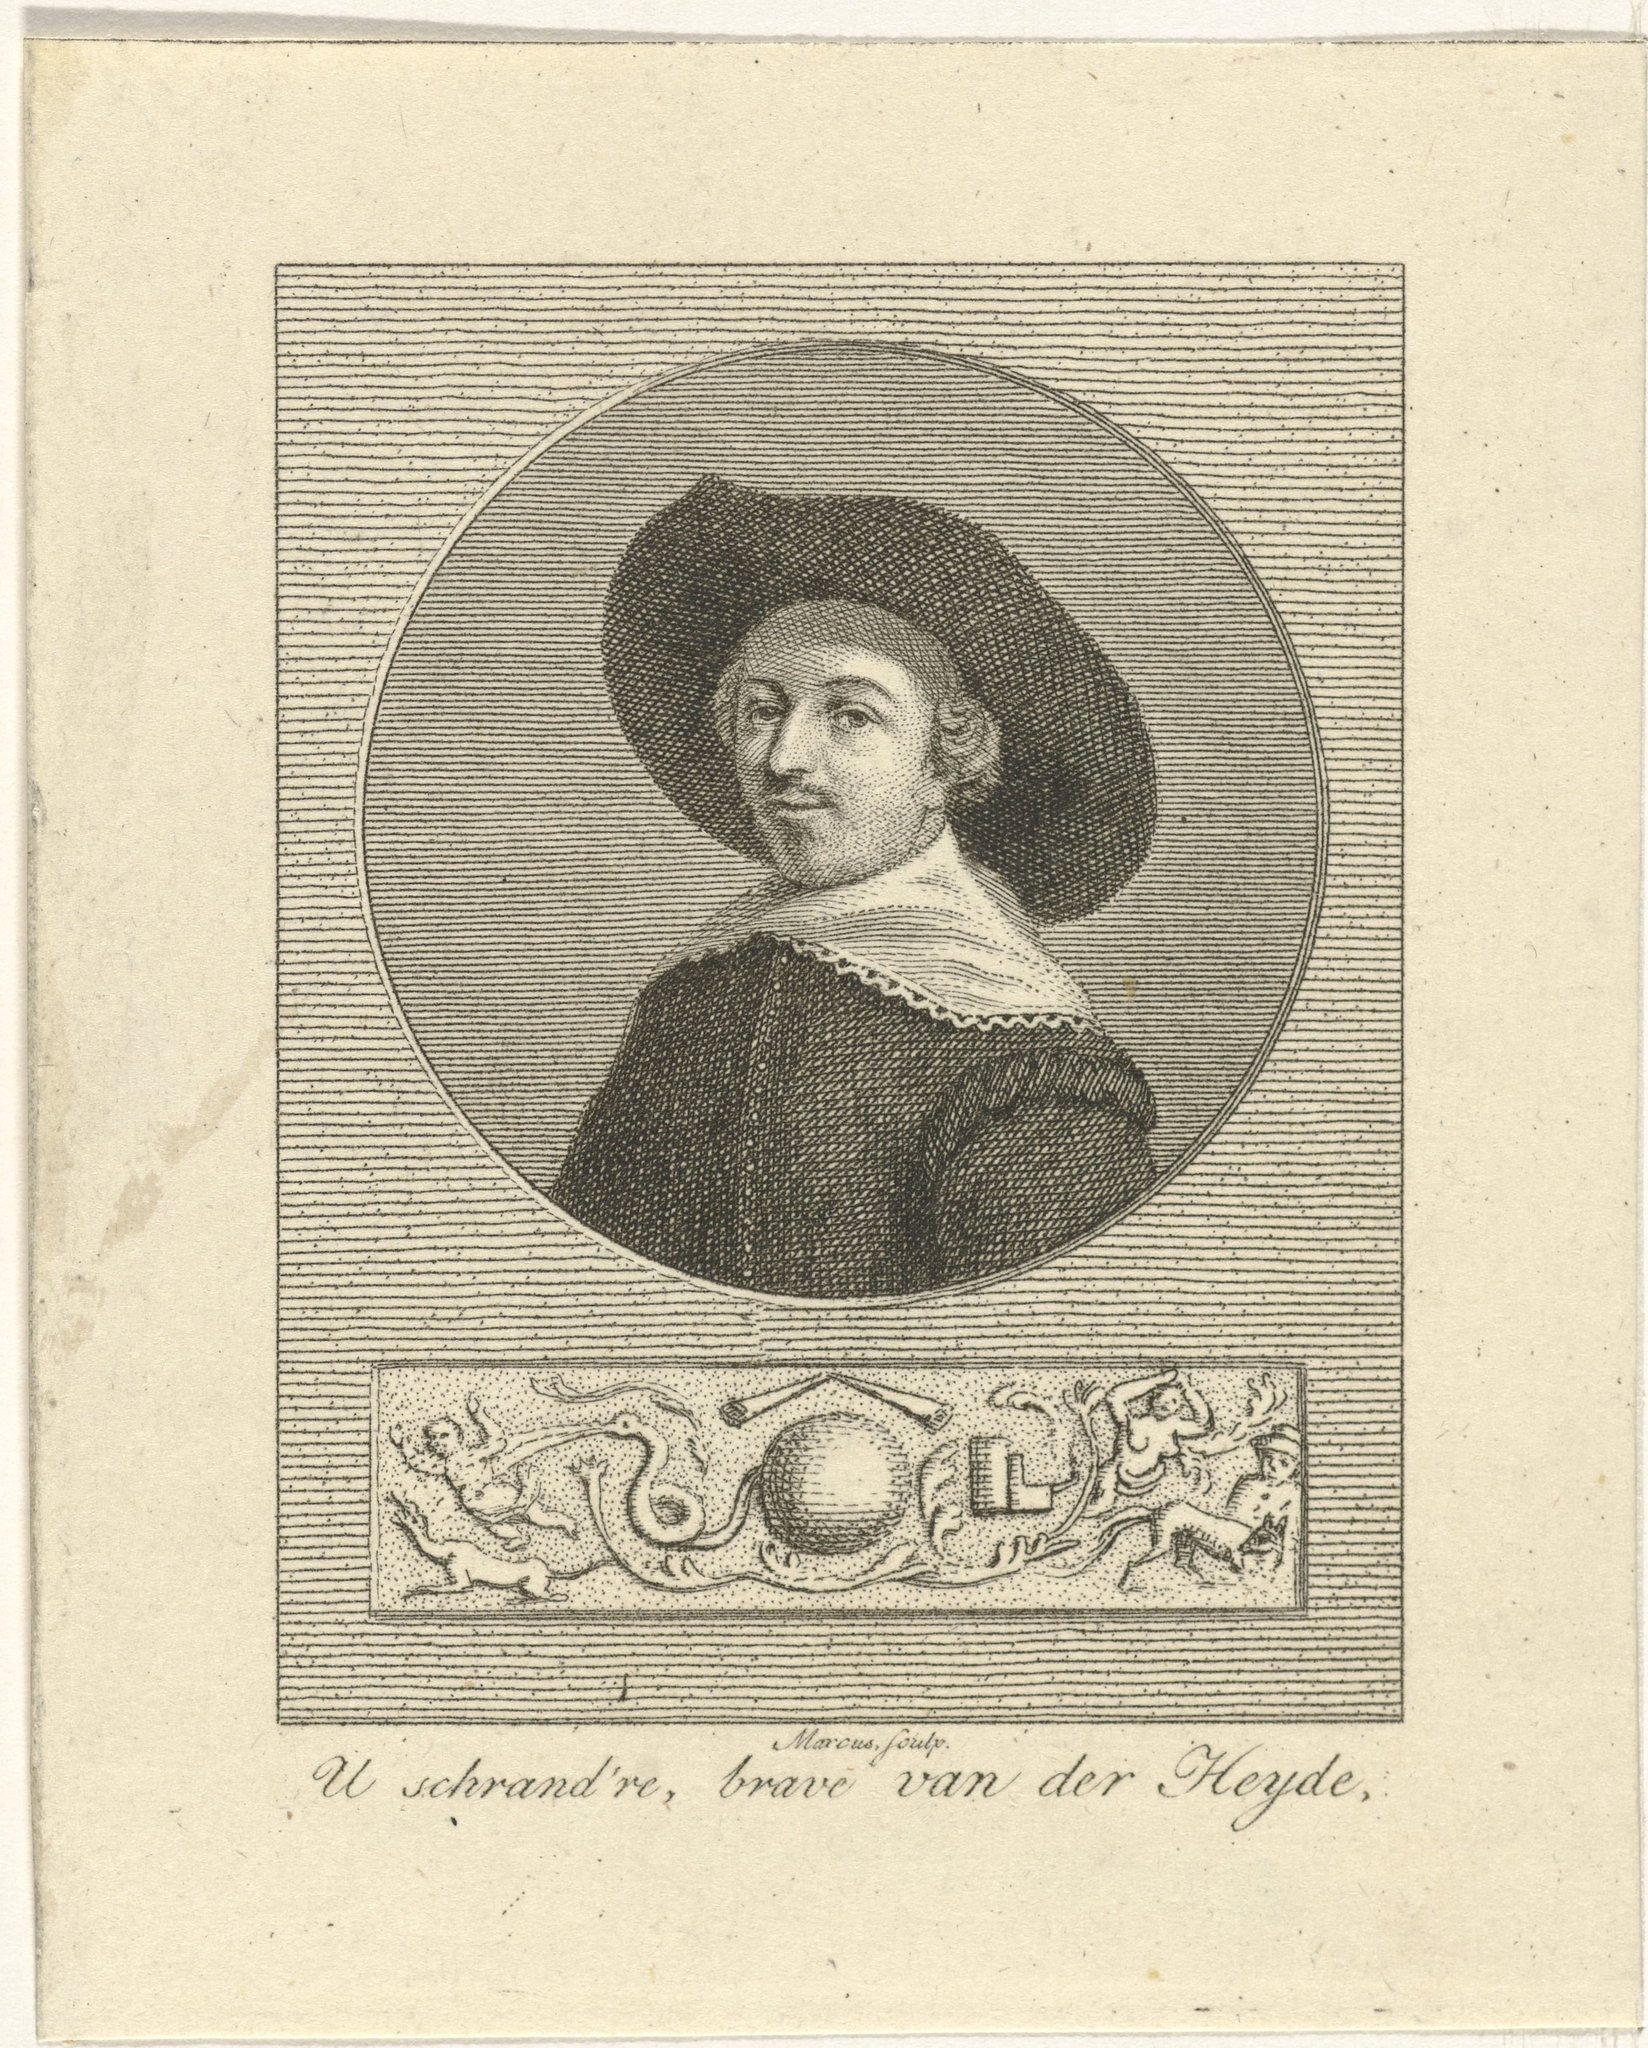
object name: print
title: Portret van Jan van der Heyden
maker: jacob ernst marcus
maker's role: draughtsman, print maker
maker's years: 1774-1826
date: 1784-1826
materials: paper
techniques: engraving, etching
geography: amsterdam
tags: amsterdam, painter, draughtsman, jan van der heyden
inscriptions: collector's mark: Lugt 2228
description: Portret van Jan van de der Heyden, kunstenaar en uitvinder van de brandspuiten. Onder het portret een plaquette met een reliëf waarop twee bazuinen, een bol, een brandspuit, dieren en figuren.